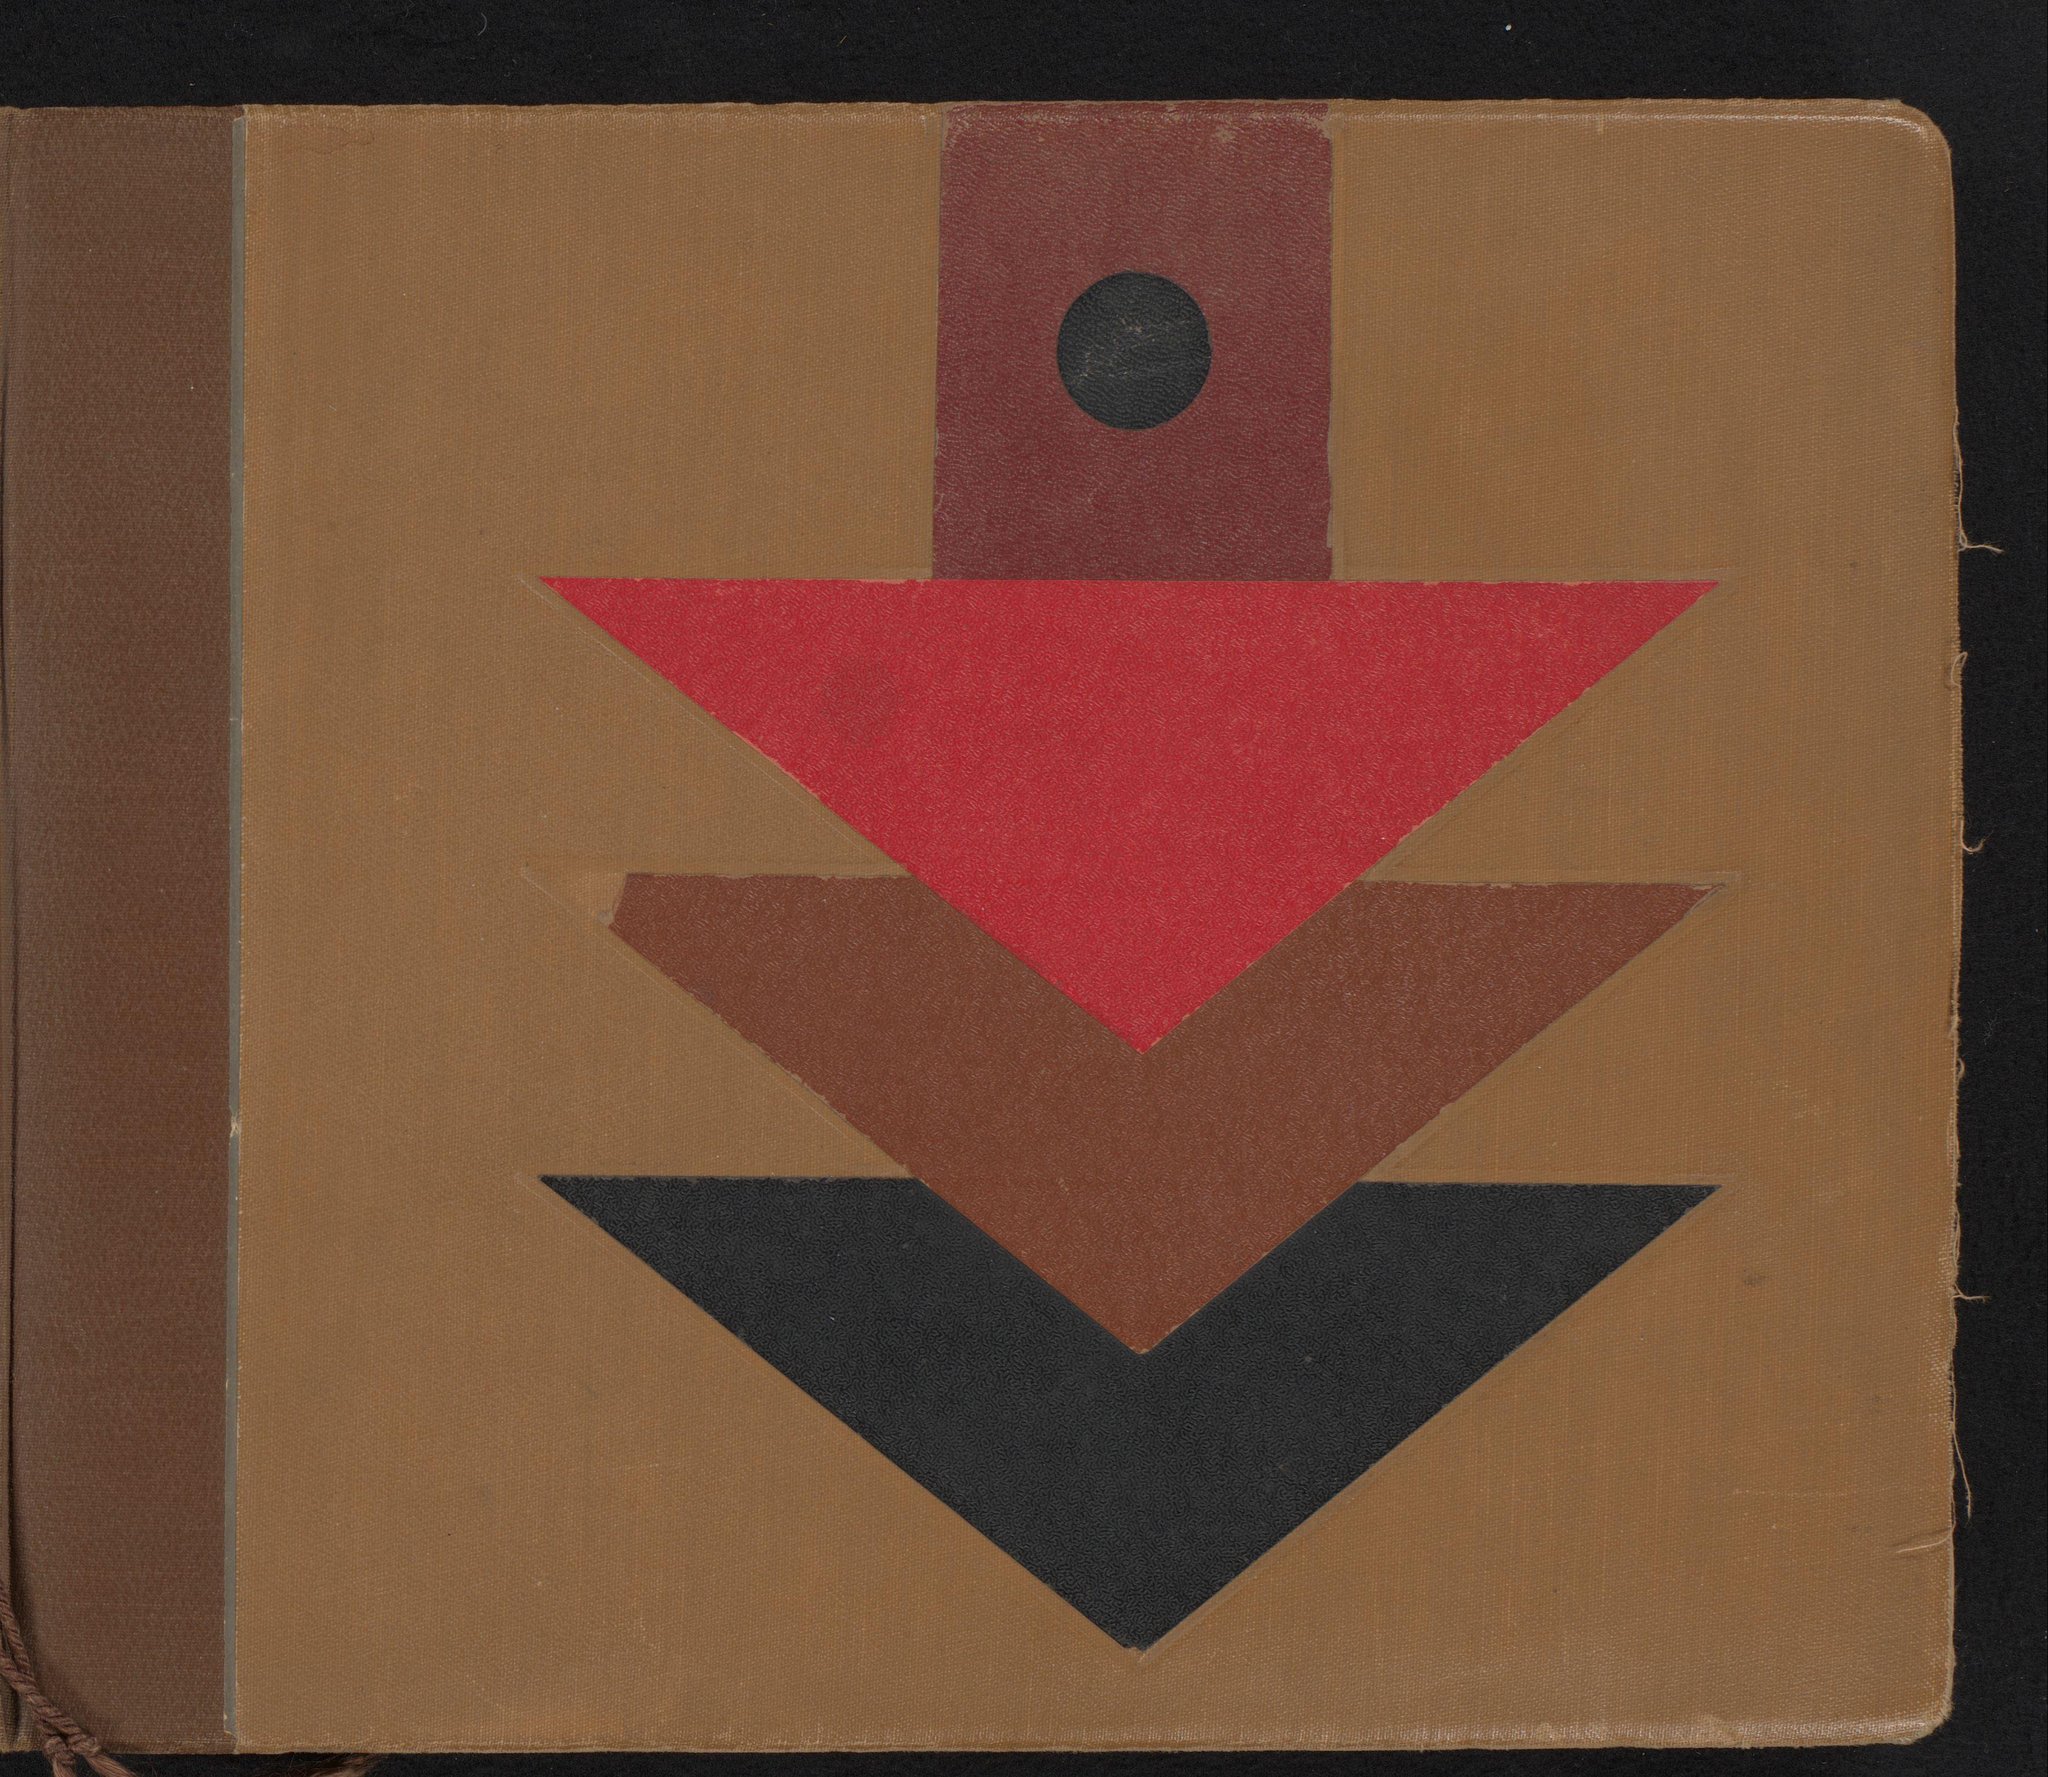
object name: scrapbook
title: Londen 1932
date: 1931-1935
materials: paper, cardboard, linen, metal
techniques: gelatin silver print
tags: henriëtte wassink, the hague, wilhelmina van zijll de jong, batavia, engineer, the family travelling, on holiday, adult woman, adult man, netherlands, italy, london, dutch east indies, the, france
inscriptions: number: ‘450’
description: Fotoalbum met 48 pagina's en in totaal 292 foto's van de familie en vrienden van Wilhelmina van Zijll de Jong. Drie foto's zitten los in het album. De foto's zijn gemaakt in Nederland en Nederlands-Indië, en op reizen naar Londen, Cambridge, Frankrijk, Egypt en Italië. Een prentbriefkaart is geplakt op een tussenblad. Het merendeel van de foto's is waarschijnlijk door Wilhelmina van Zijll de Jong zelf gemaakt, van andere foto's is de maker anoniem.